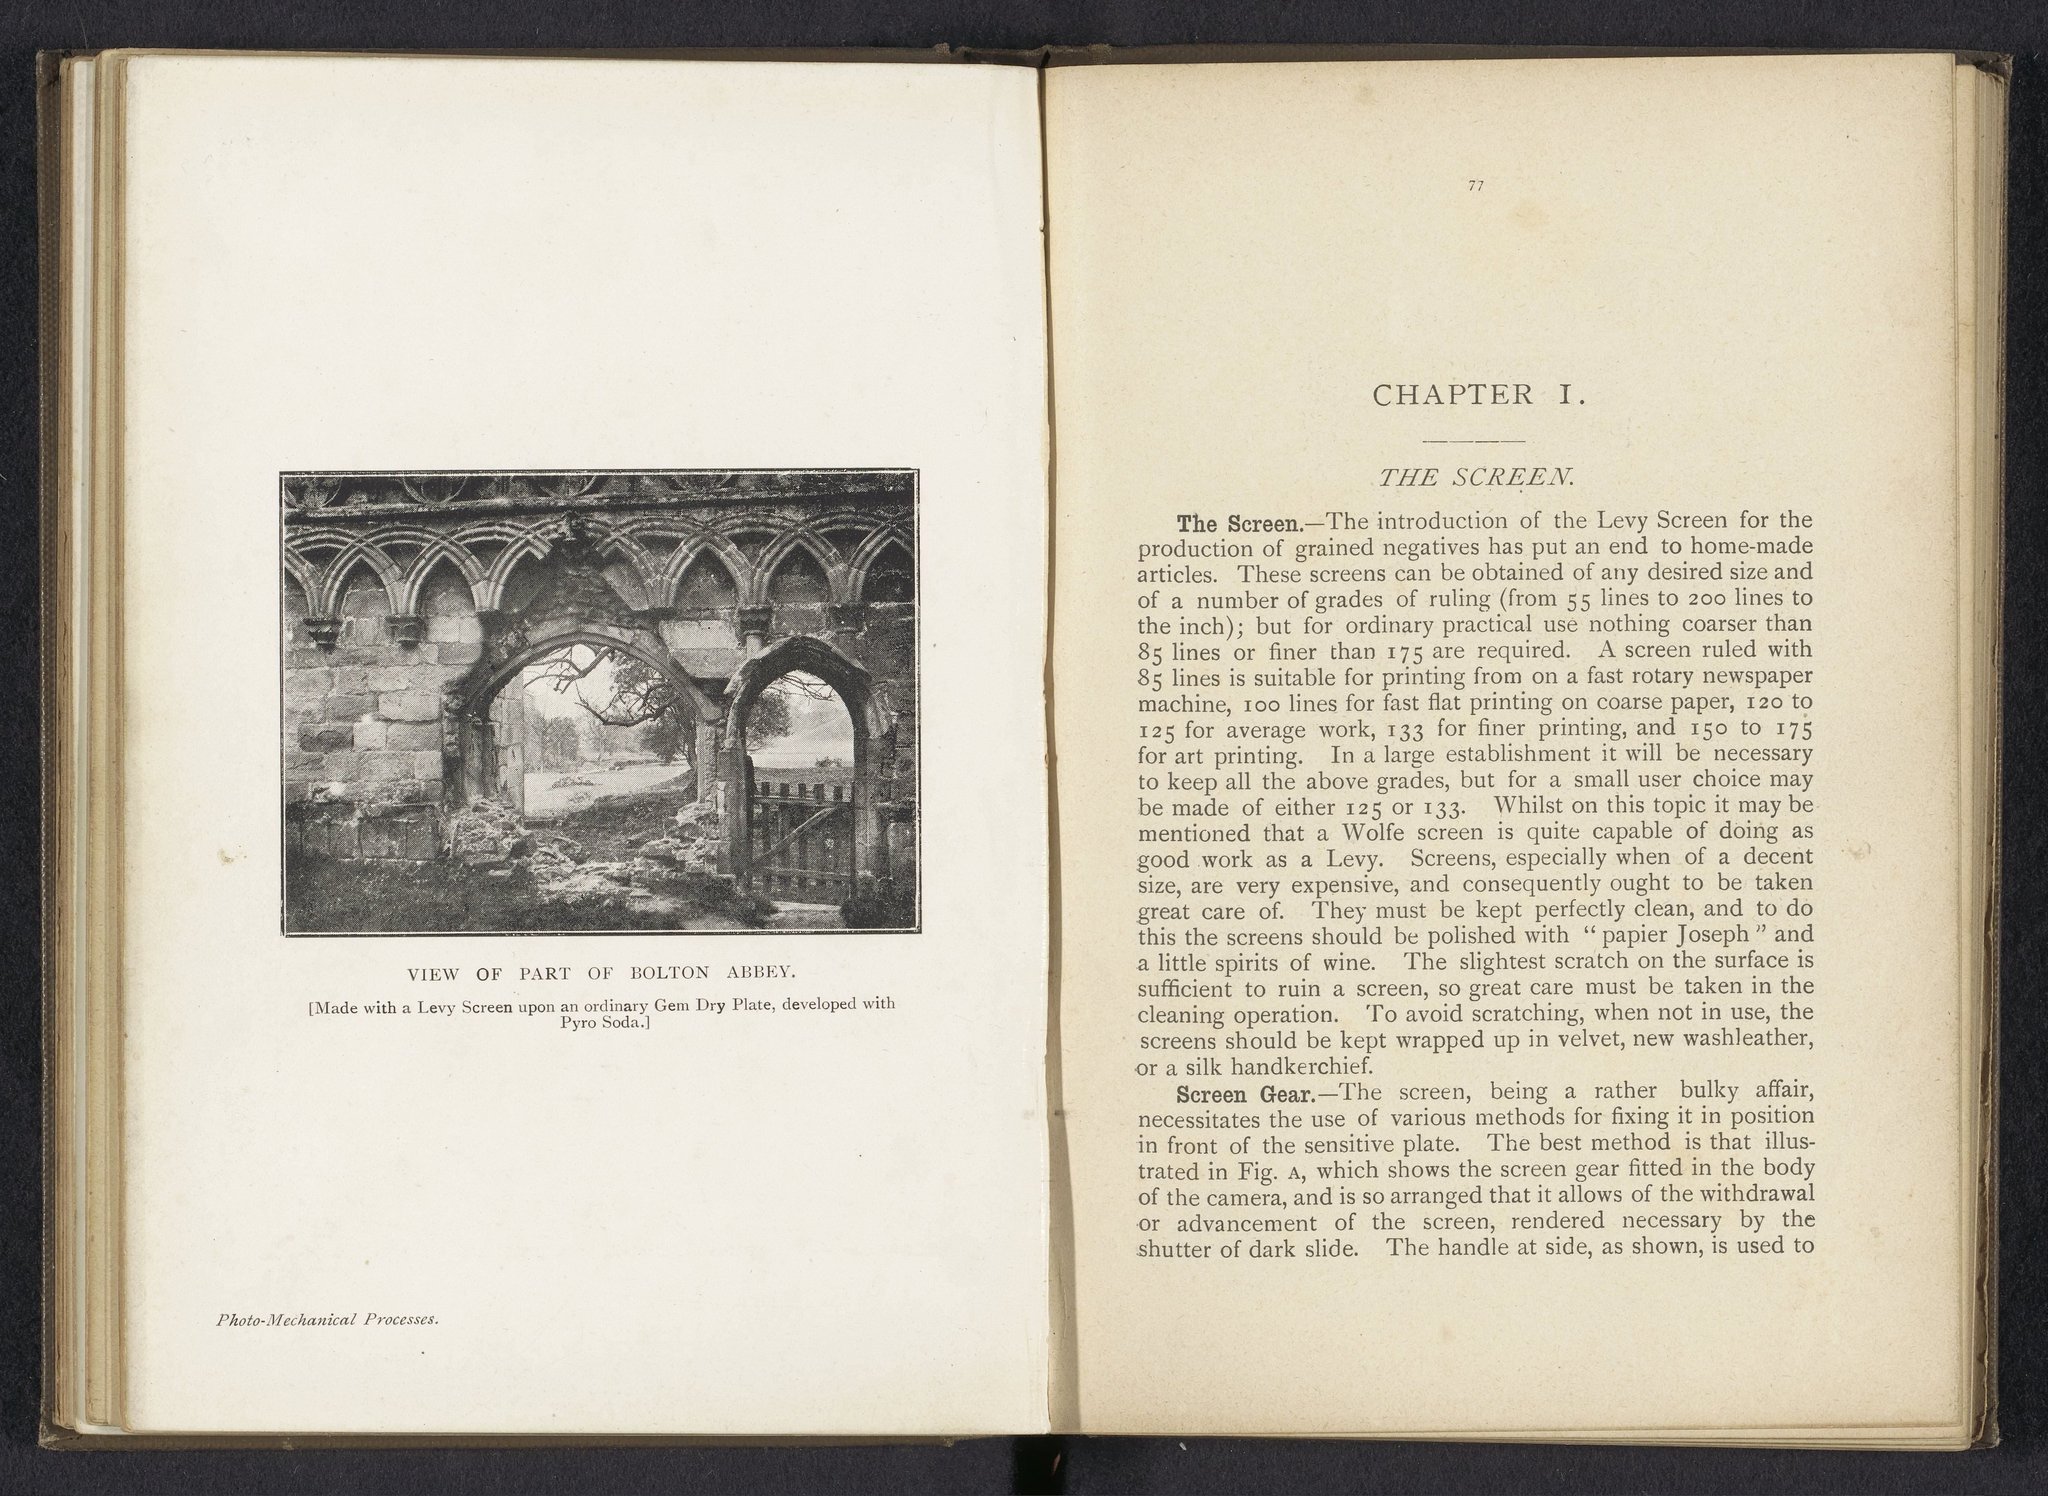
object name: photomechanical print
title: View of part of Bolton Abbey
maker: Anonymous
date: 1887-1897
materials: paper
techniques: autotype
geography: wharfedale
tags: abbey wall